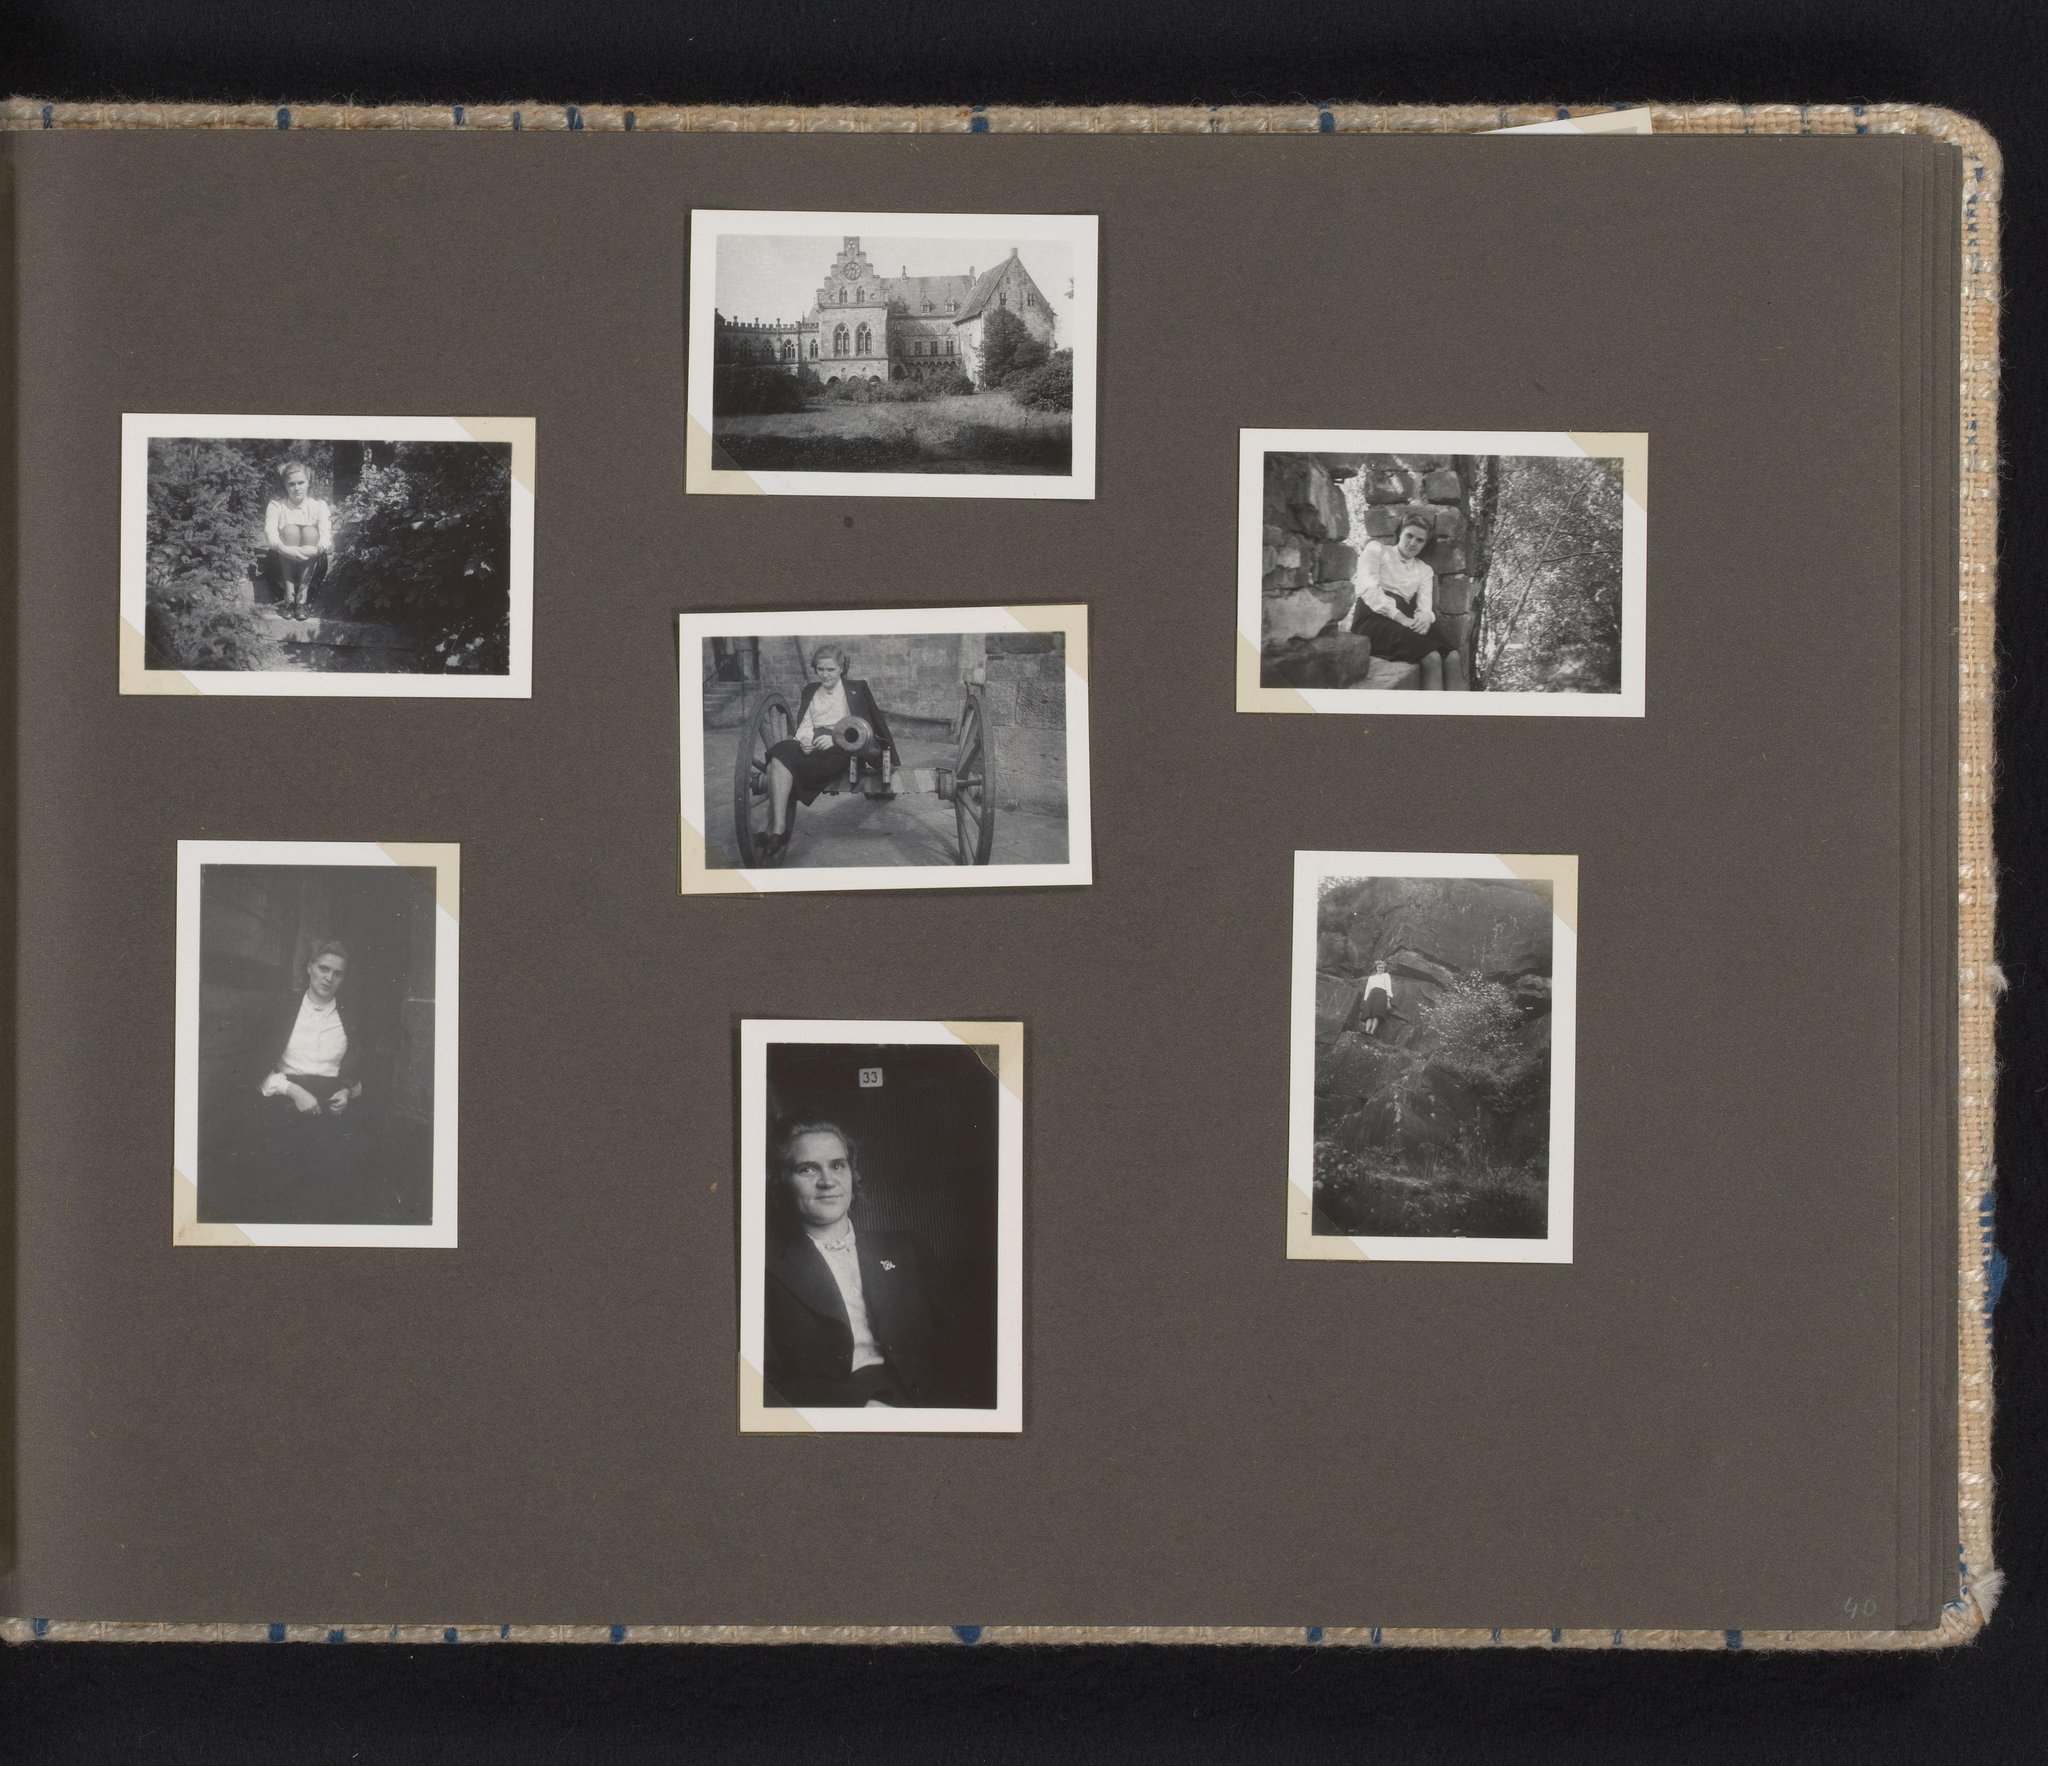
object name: photograph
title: Zagreb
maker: Anonymous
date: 1943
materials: cardboard, photographic support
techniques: gelatin silver print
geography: zagreb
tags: leave ~ the soldier off duty, occupation ~ war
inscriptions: date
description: Albumblad met zeven foto's van de dochter, in een park bij een kerk, waarschijnlijk in Zagreb. Onderdeel van het fotoalbum Abrechnungsintendantur van de Wehrmacht 1941-1943.